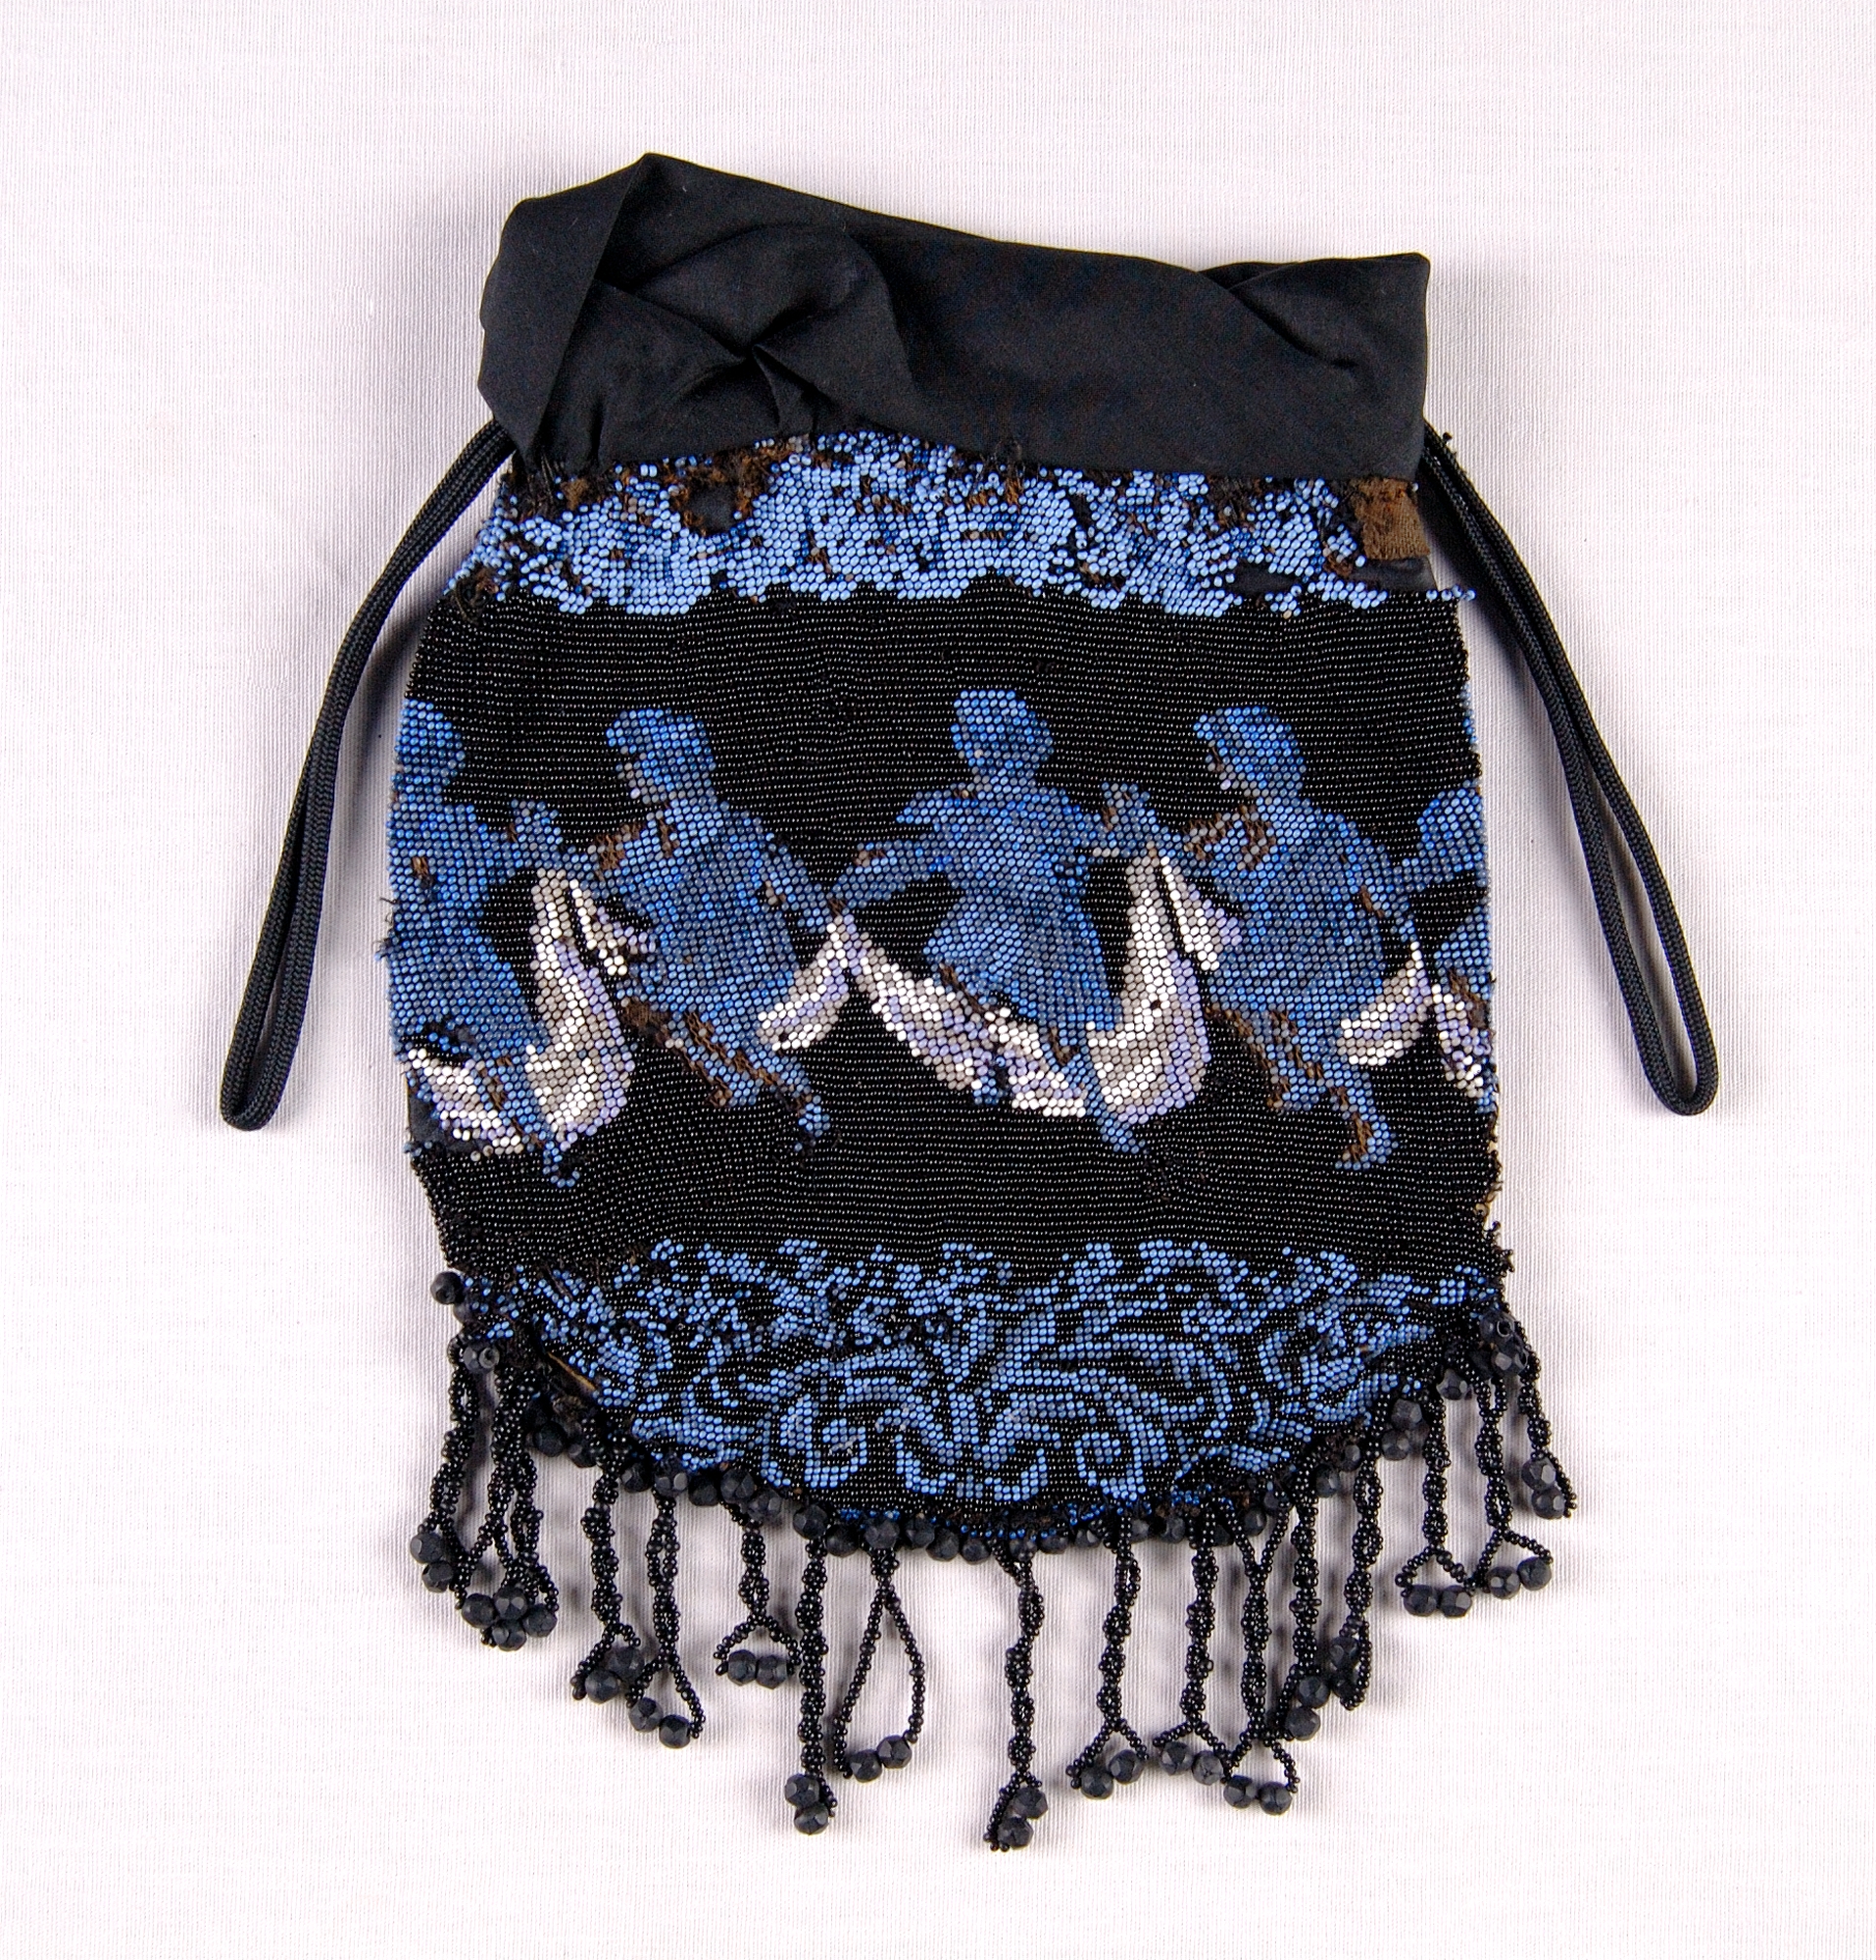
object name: pouch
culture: american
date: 1840-1860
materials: glass, leather, linen, silk